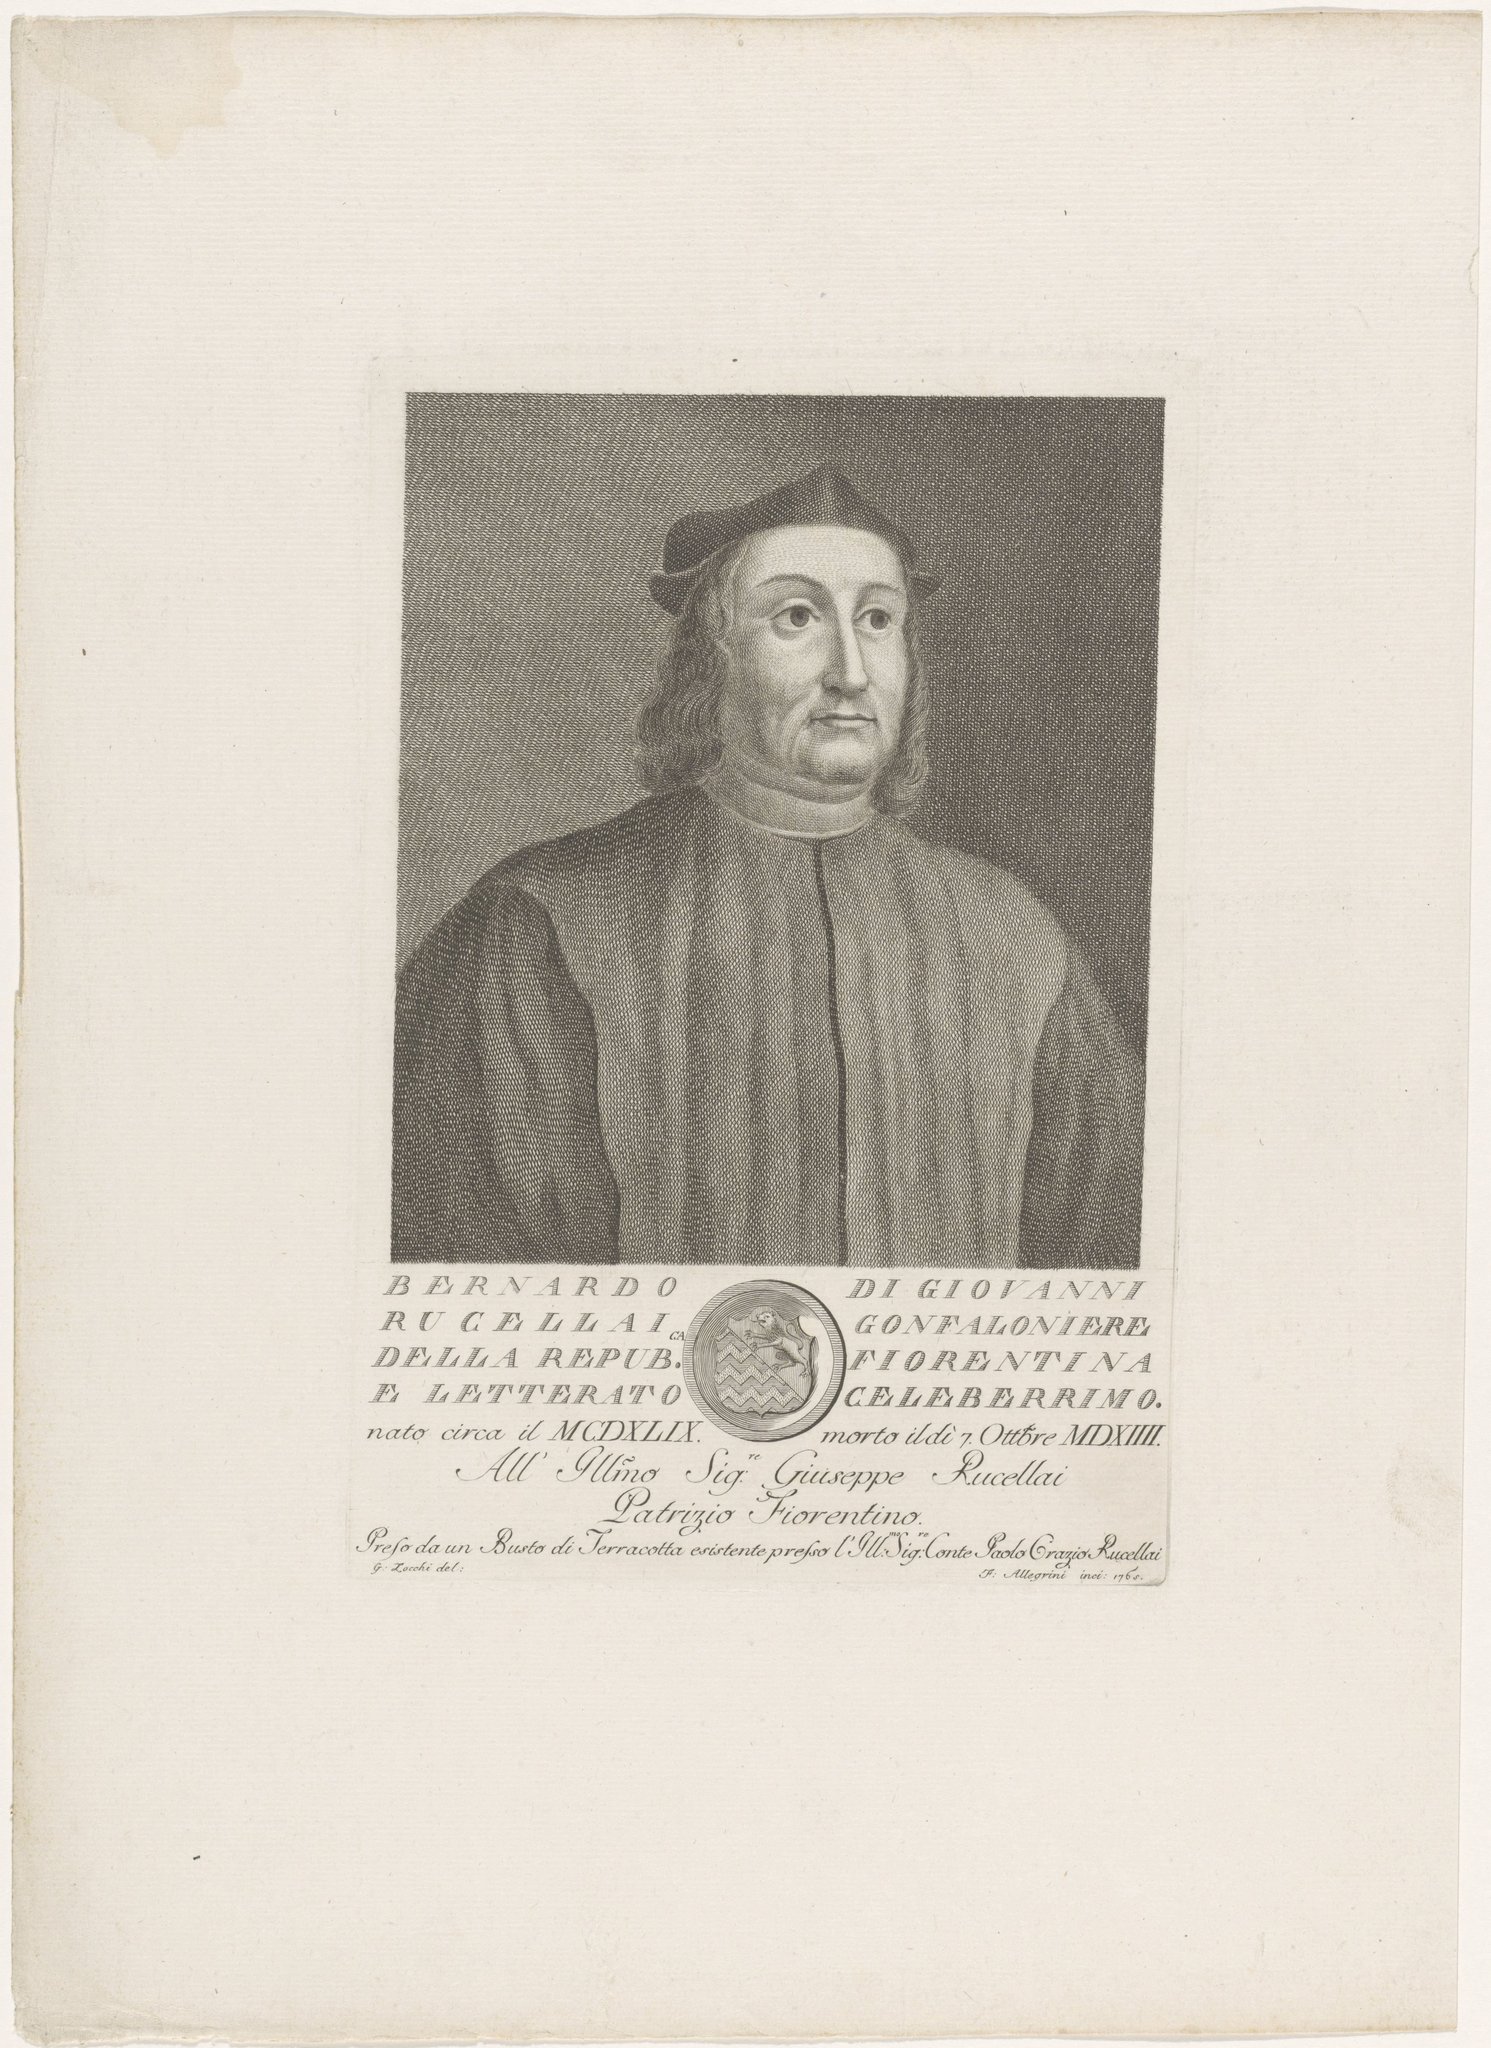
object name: print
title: Portretten van beroemde Italianen met wapenschild in ondermarge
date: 1765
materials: paper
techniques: engraving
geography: italy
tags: historical persons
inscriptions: collector's mark: Lugt 2228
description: Deze prent maakt deel uit van een reeks portretprenten van onbekende omvang. De prenten zijn gemaakt door meedere prentmakers, onder wie Francesco Allegrini en Carlo en Raimondo Faucci.